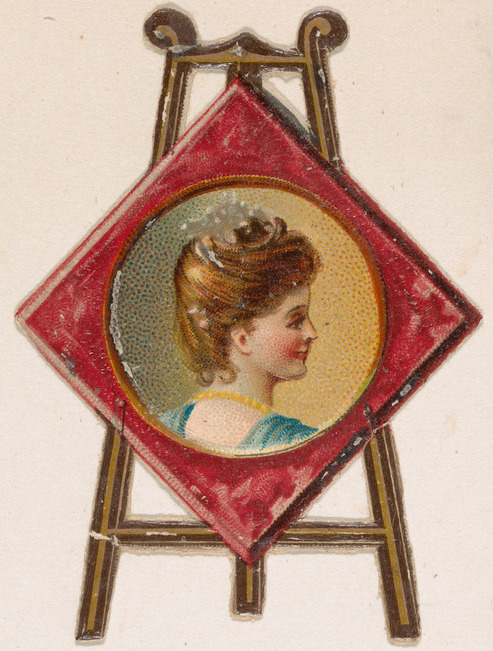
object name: print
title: Painting easel, from the Novelties series (N228, Type 4) issued by Kinney Bros.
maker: kinney brothers tobacco company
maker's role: publisher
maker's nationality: american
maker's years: 1869-2011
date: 1889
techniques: color lithograph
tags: women